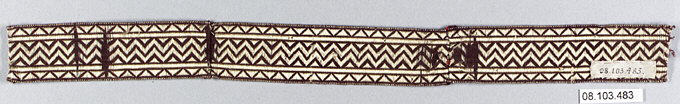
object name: galloon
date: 1801-1900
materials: metal thread